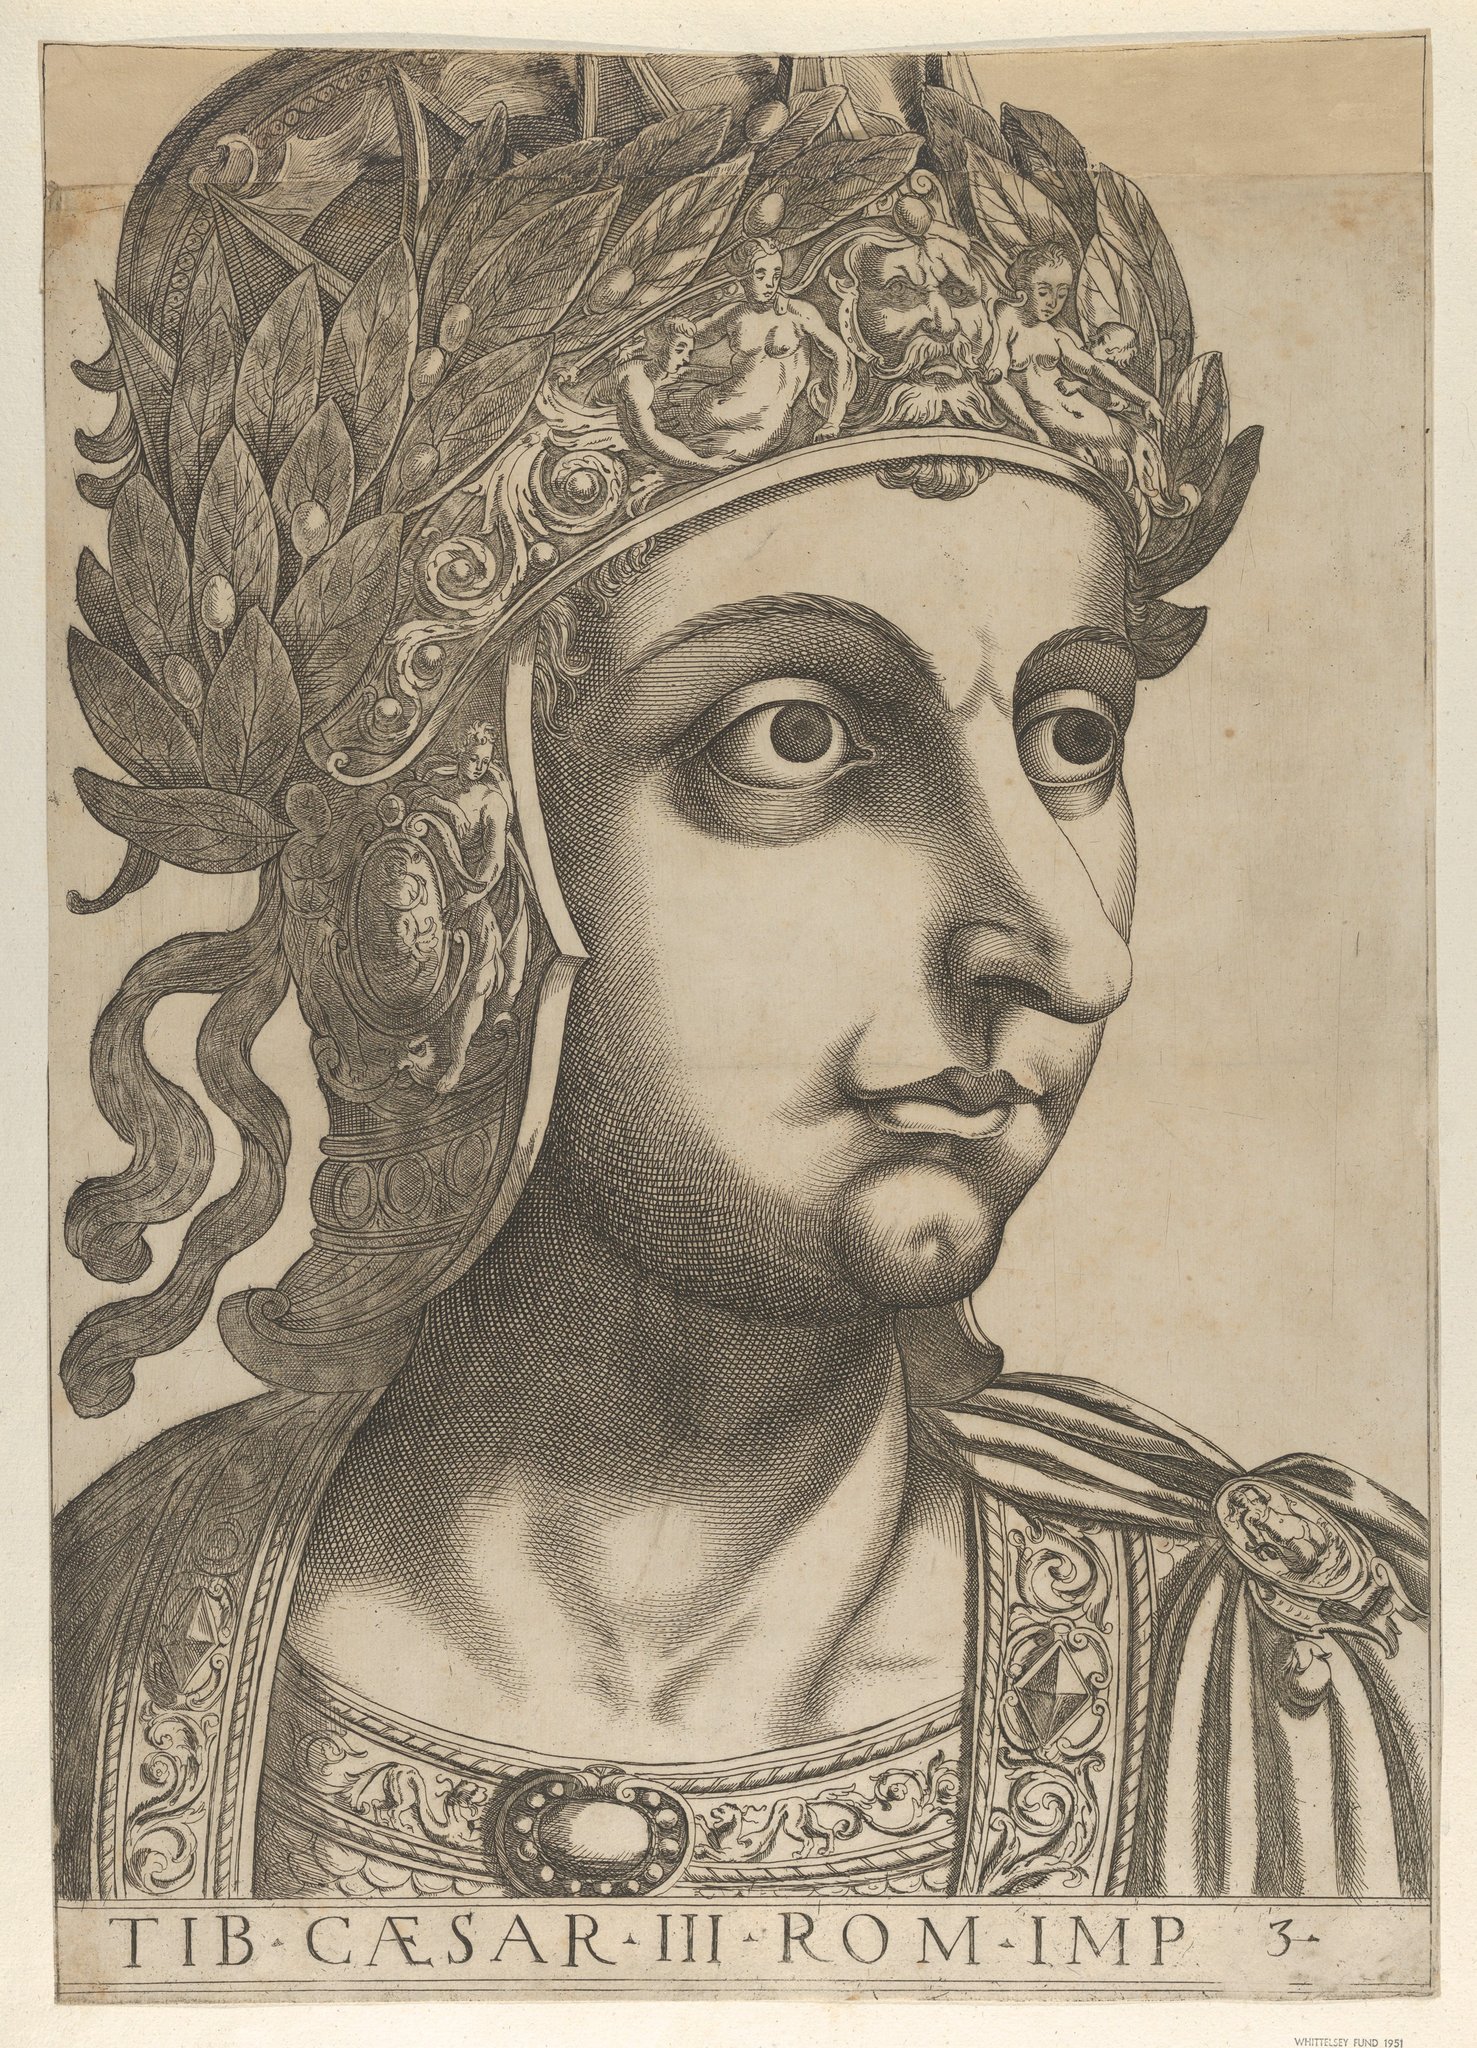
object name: print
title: Plate 3: Tiberius turned to the right, from 'The Twelve Caesars'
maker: Anonymous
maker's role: artist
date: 1610-1640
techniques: engraving, etching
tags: men,portraits